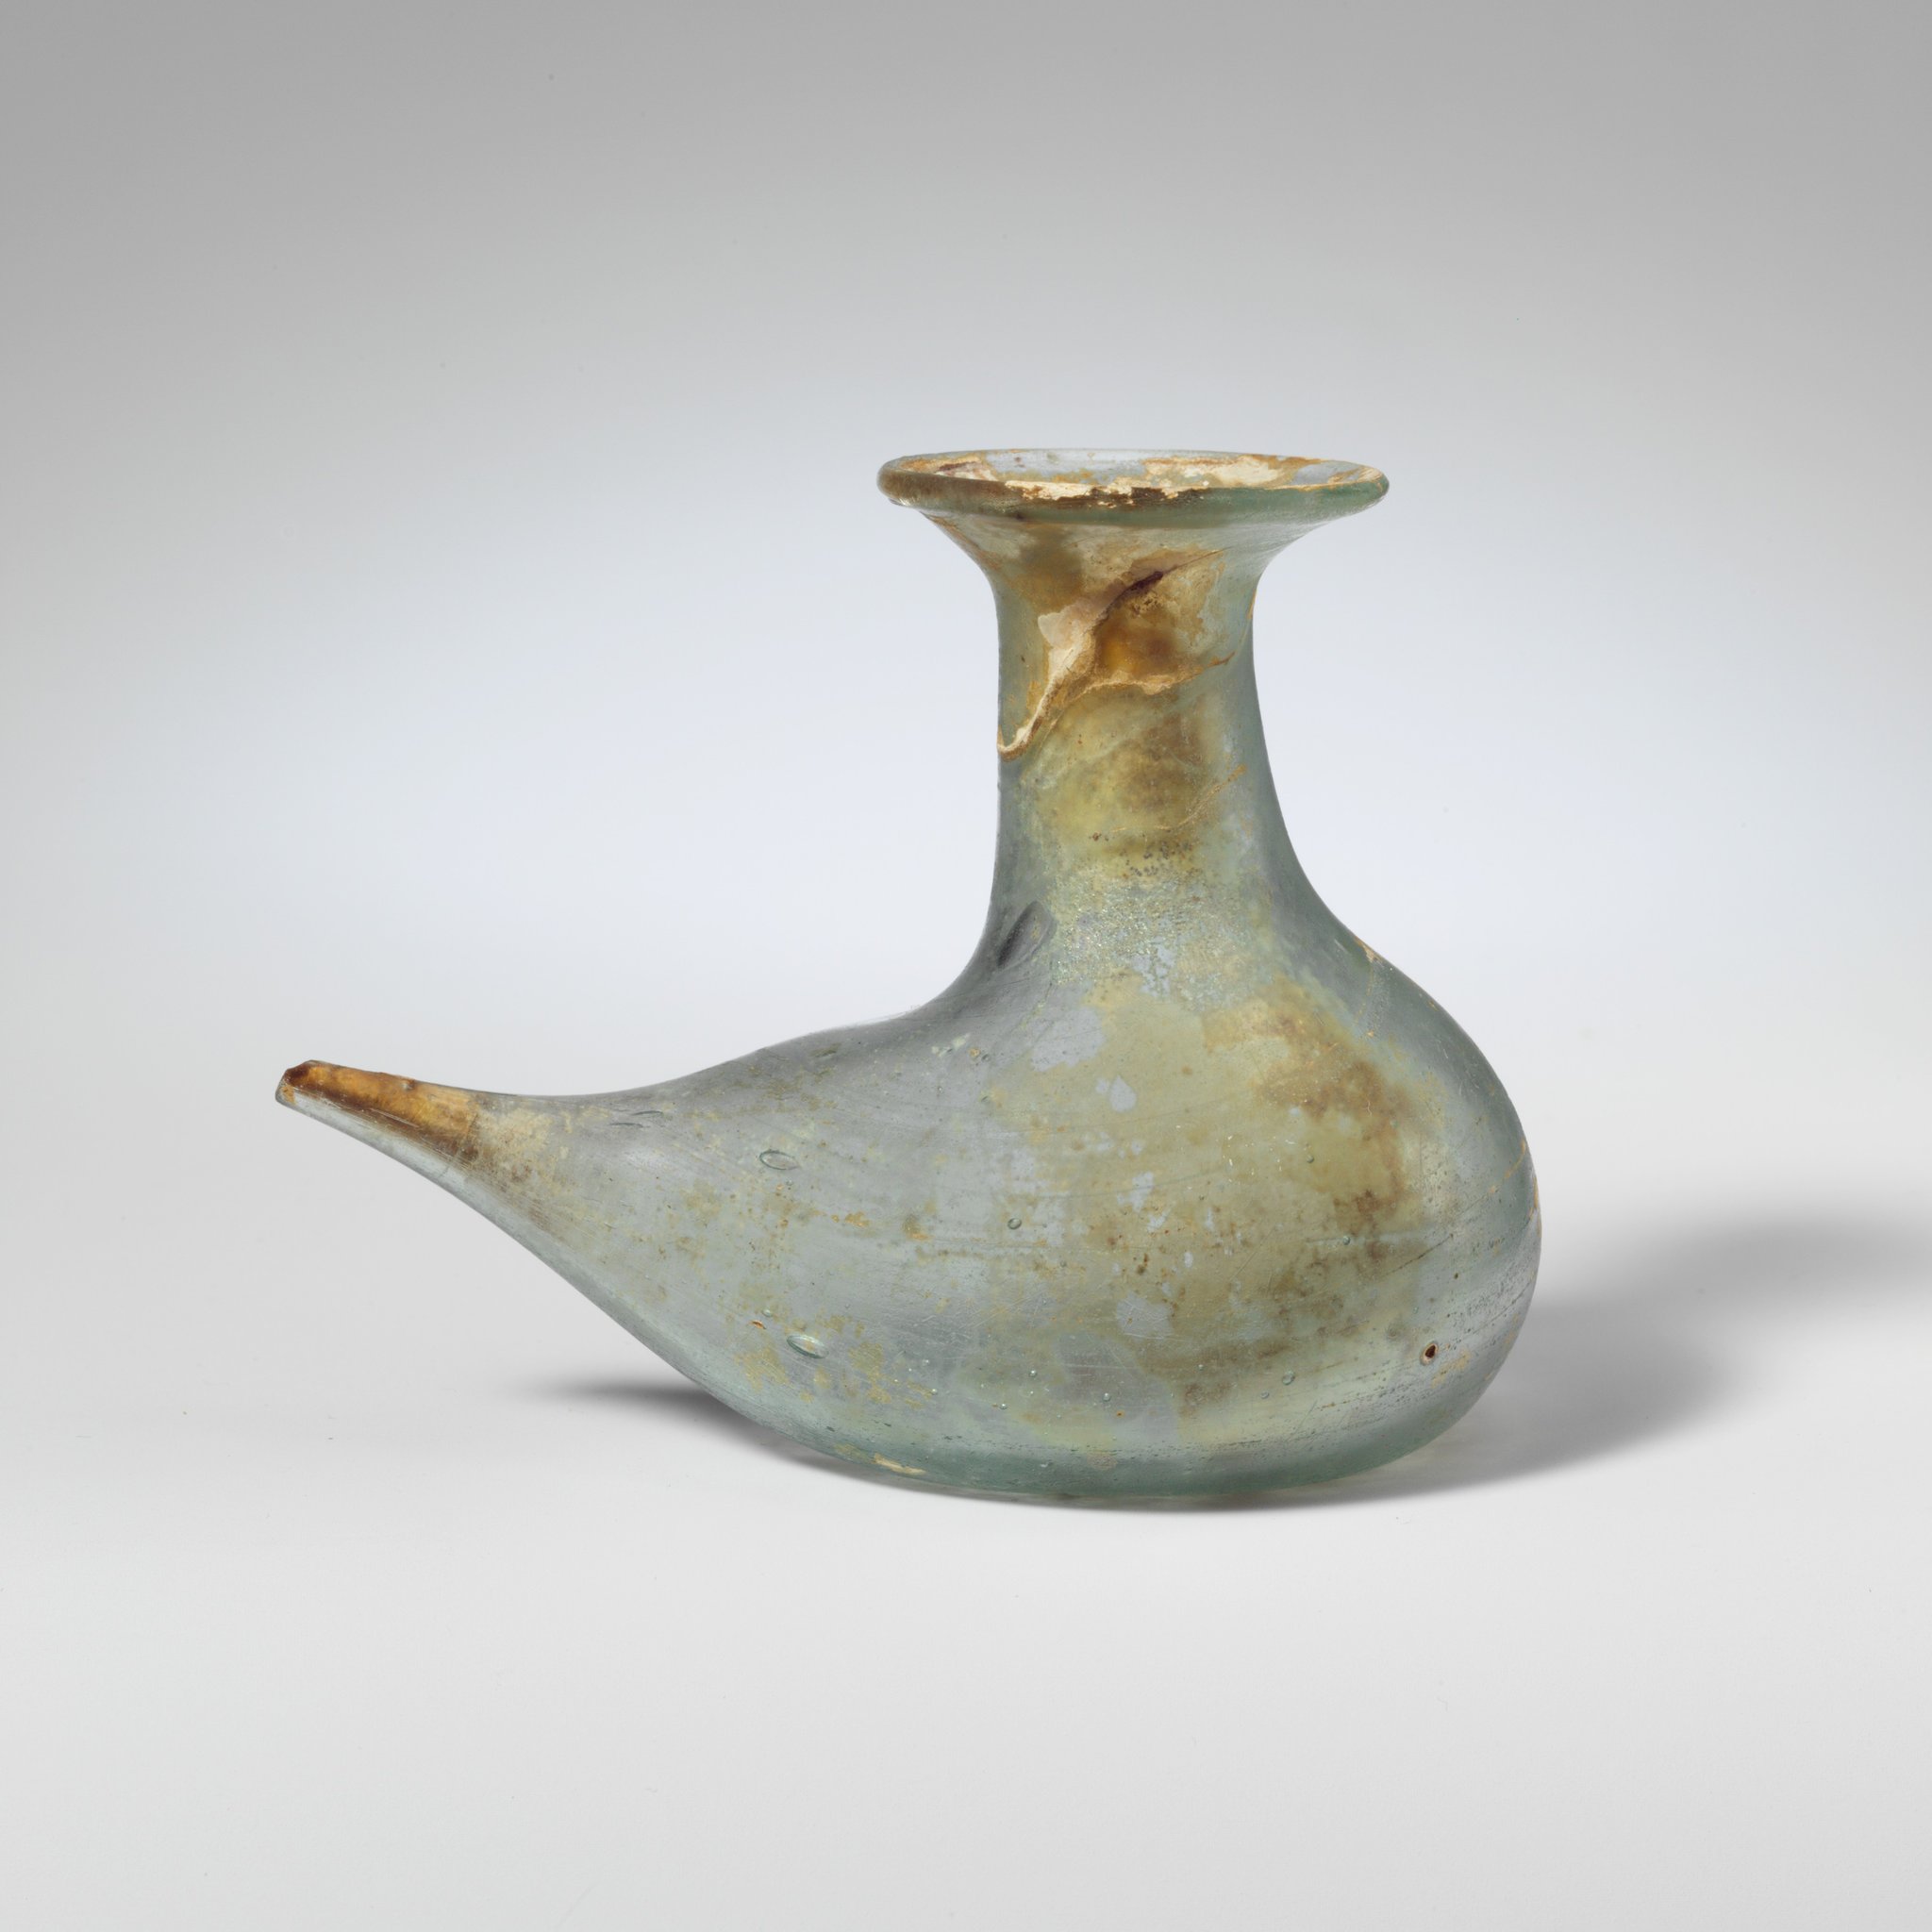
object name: pourer flask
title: Glass pourer flask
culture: roman, cypriot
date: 101-233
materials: glass